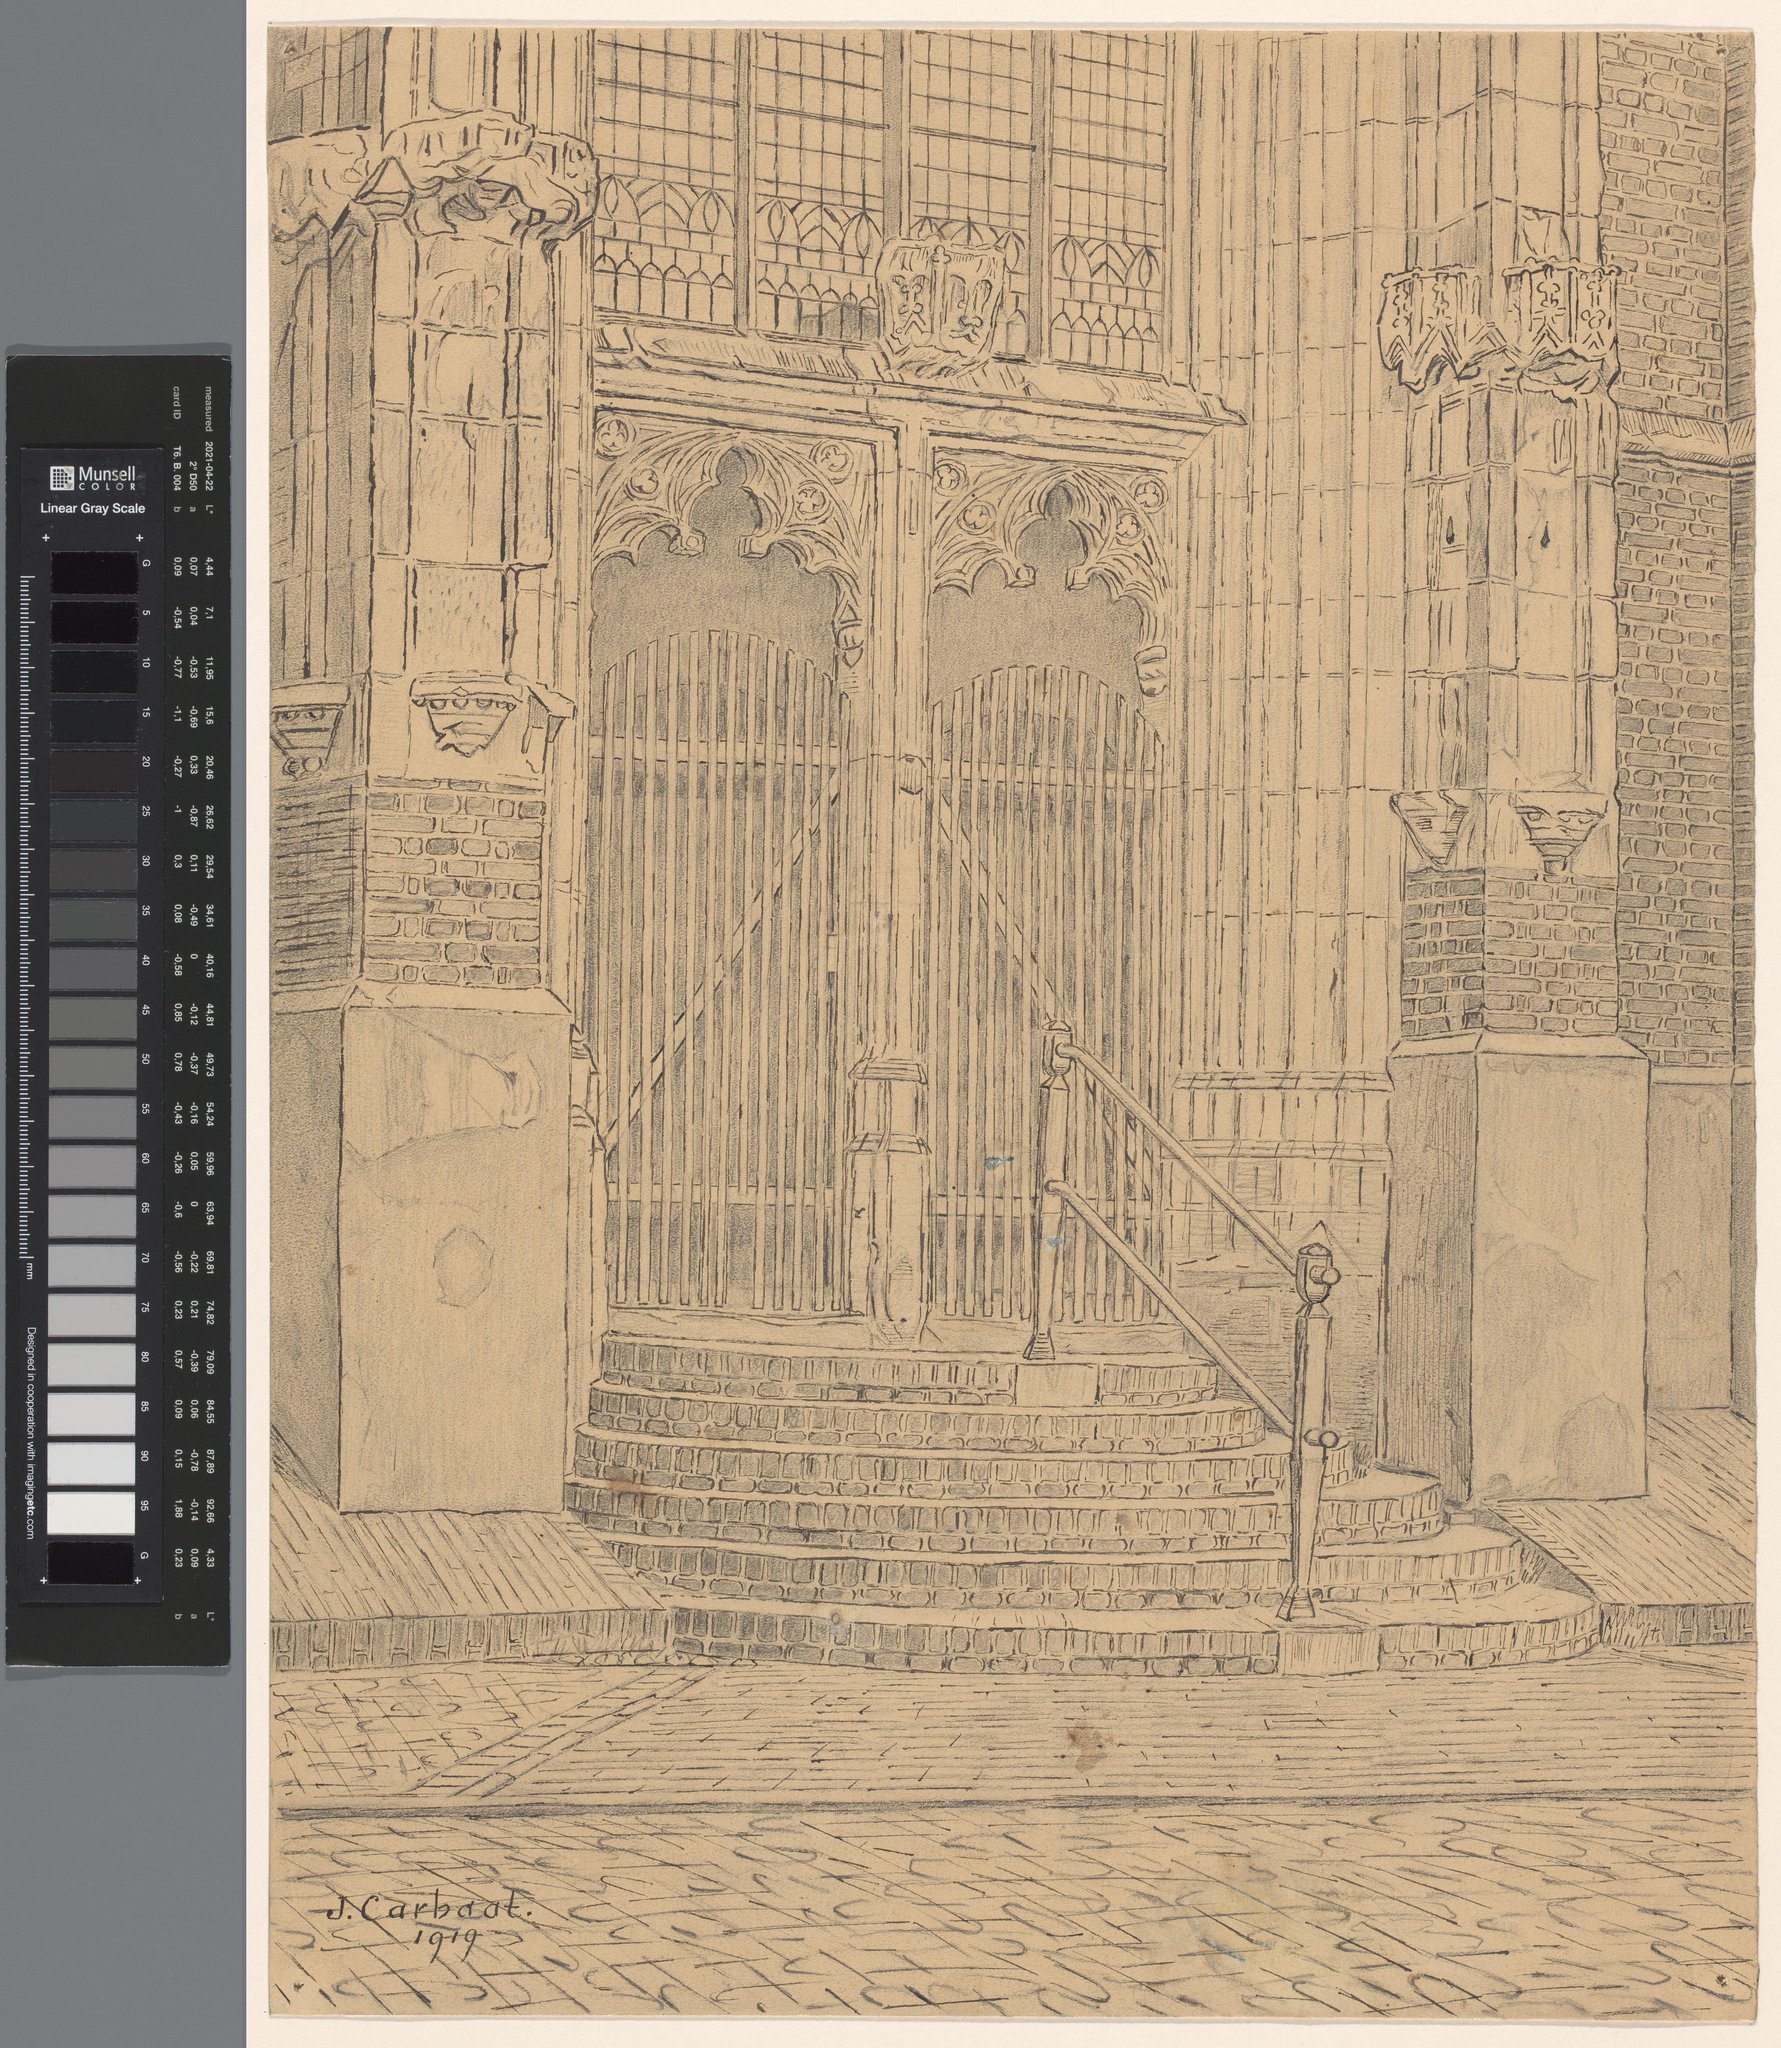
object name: drawing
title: Portaal van een kerk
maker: jan carbaat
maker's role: draughtsman, painter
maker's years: 1866-1925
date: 1919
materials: ink, paper, pencil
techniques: pen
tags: parts of church exterior and annexes: porch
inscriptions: date